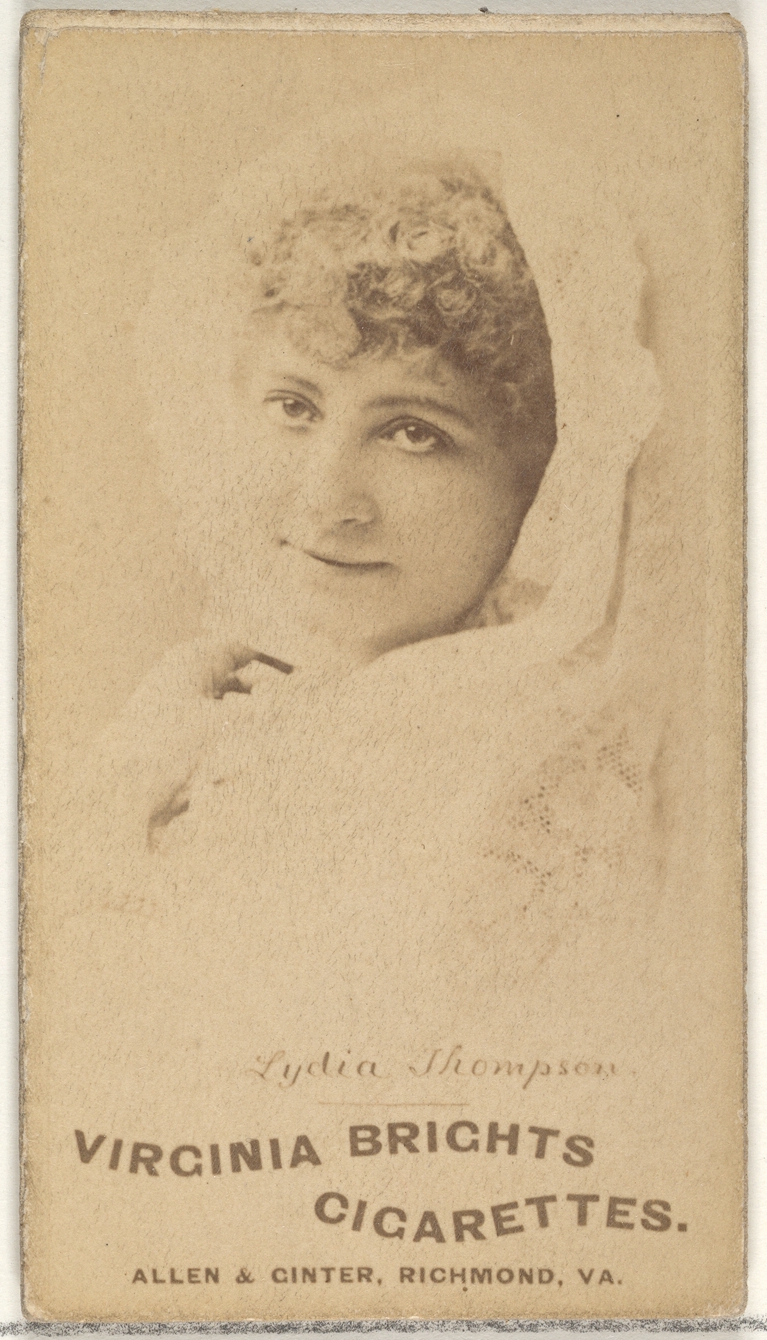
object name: photograph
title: Lydia Thompson, from the Actors and Actresses series (N45, Type 1) for Virginia Brights Cigarettes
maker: allen & ginter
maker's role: publisher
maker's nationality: american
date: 1888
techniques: albumen silver print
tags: portraits,women,actresses